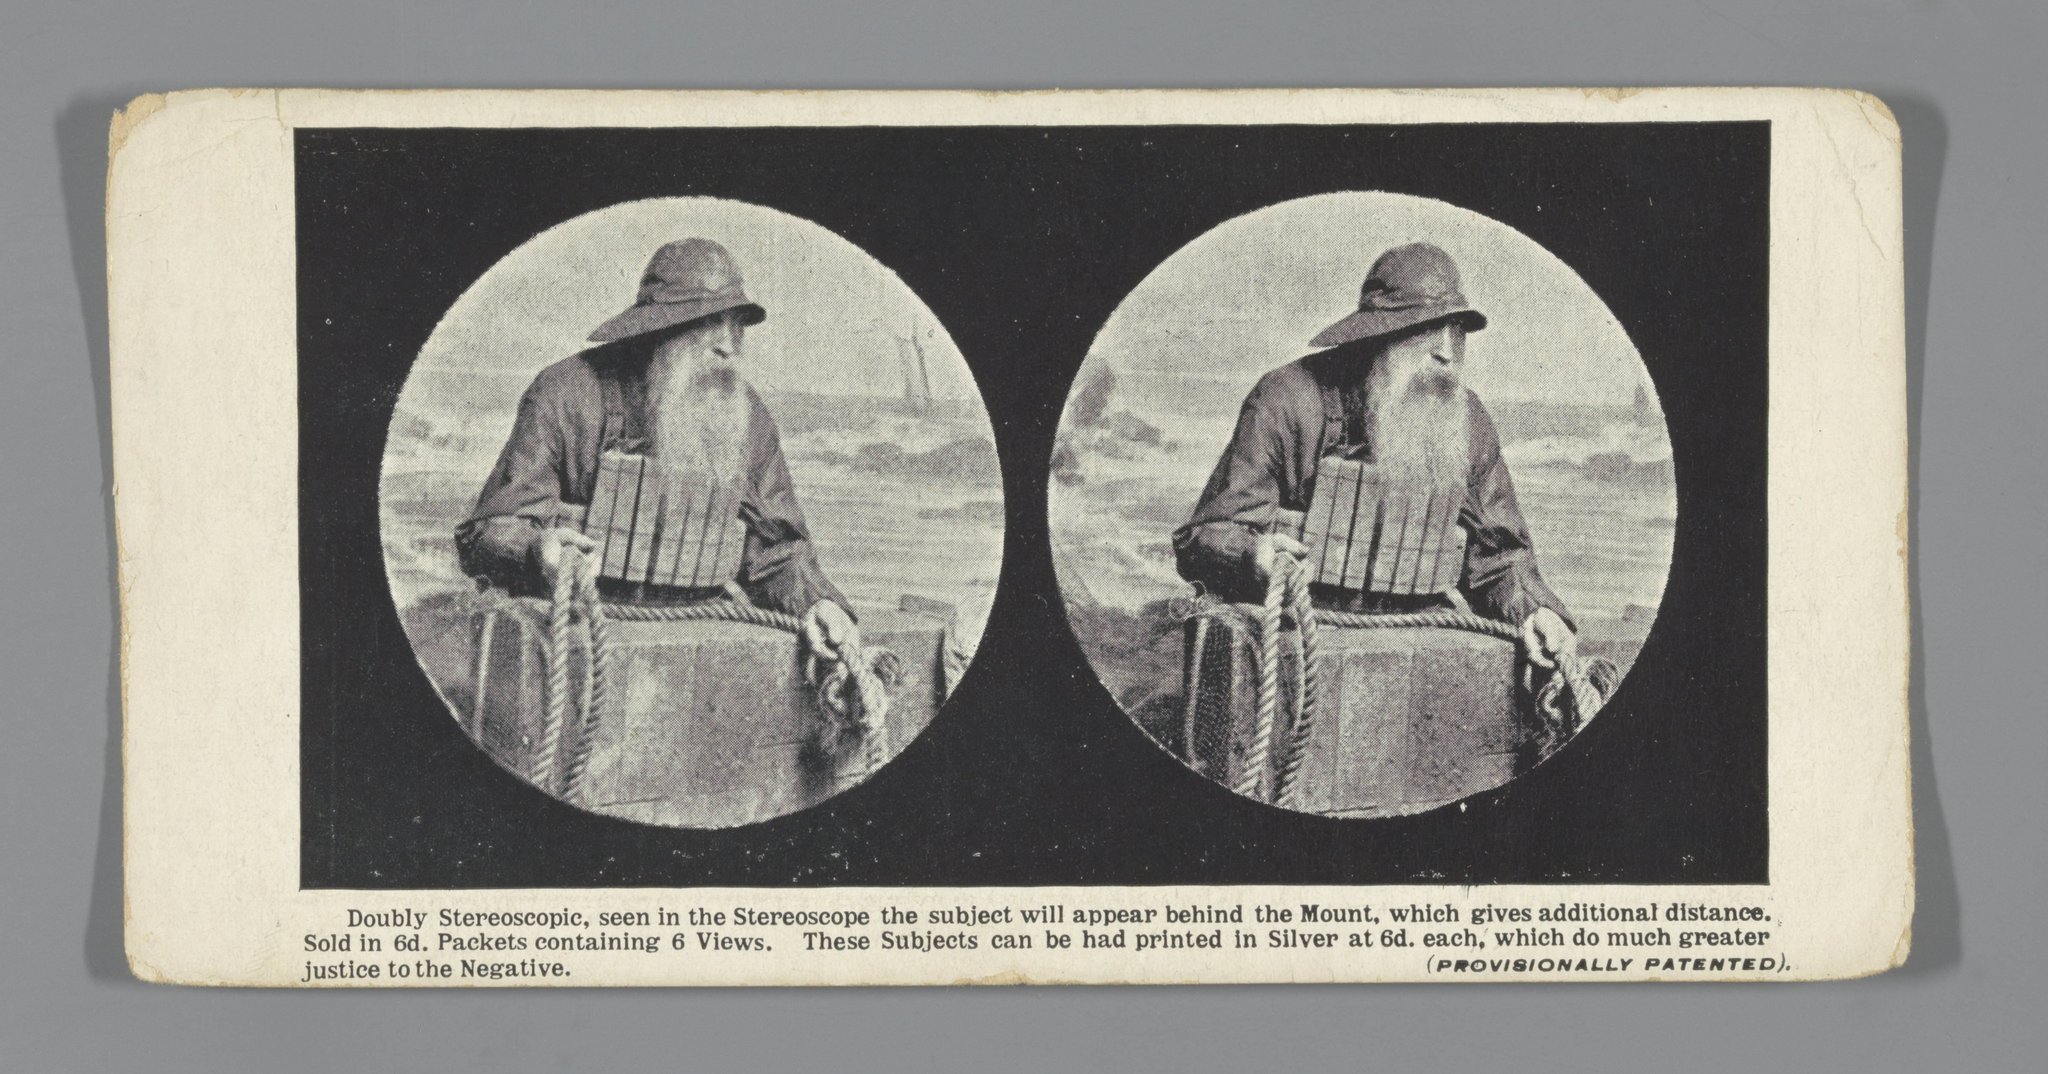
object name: stereograph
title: Zeeman voor een zeedecor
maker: Anonymous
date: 1880-1910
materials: cardboard, paper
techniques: autotype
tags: fisherman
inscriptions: : ‘Doubly Stereoscopic, seen in the Stereoscope the subject will appear behind the Mount (...)’